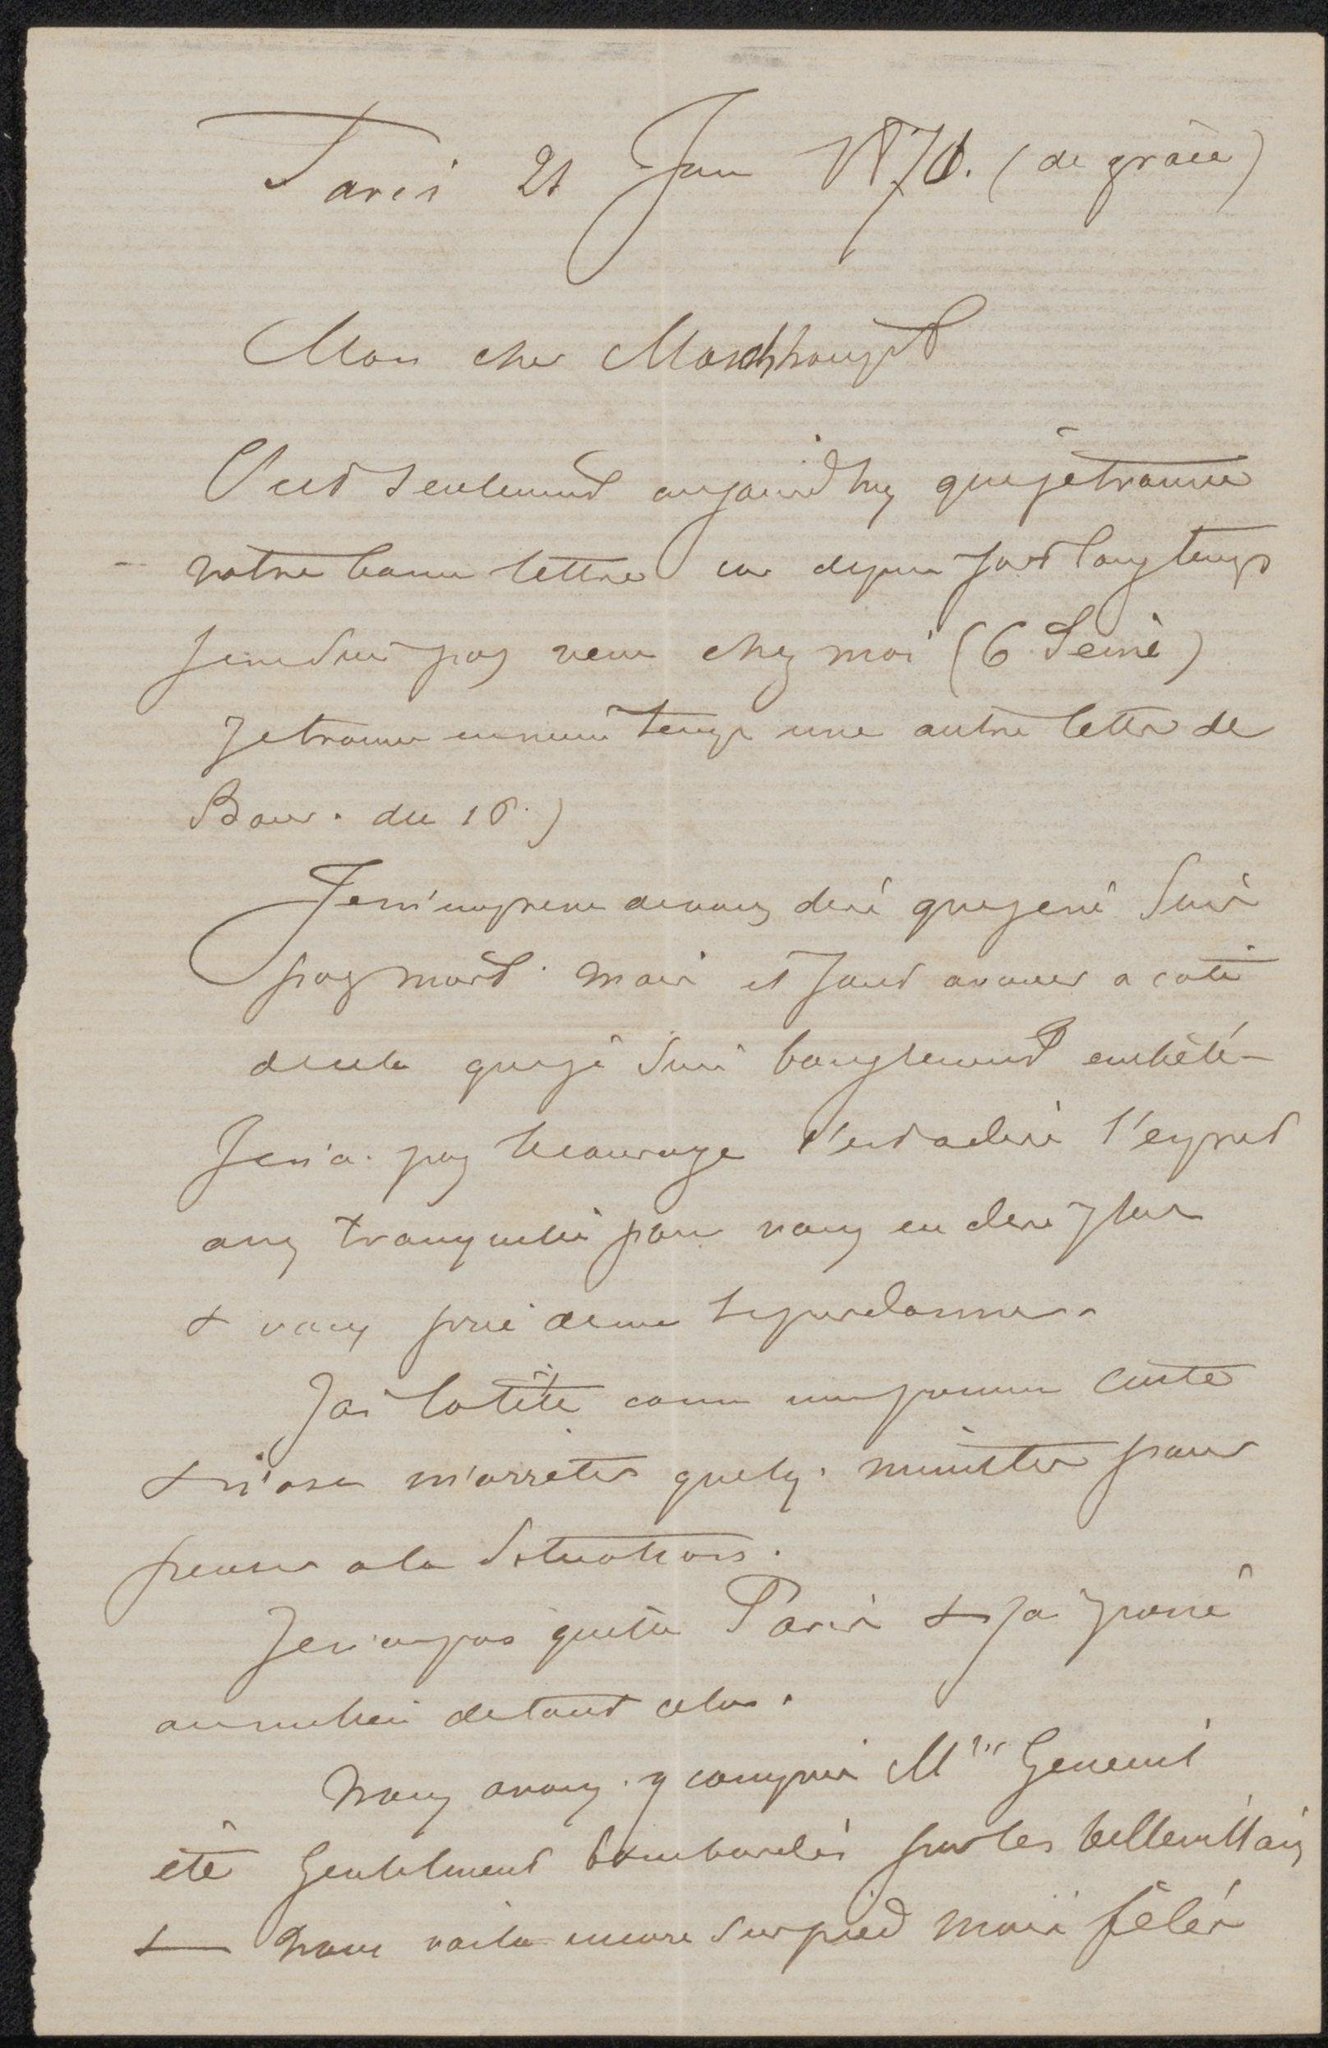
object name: letter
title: Brief aan Jan Hendrik Maschaupt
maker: adolphe mouilleron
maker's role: draughtsman, print maker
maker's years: 1820-1881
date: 1870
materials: ink, paper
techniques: pen, writing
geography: paris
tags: painter, jan hendrik maschaupt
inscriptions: collector's mark: ‘RPK’